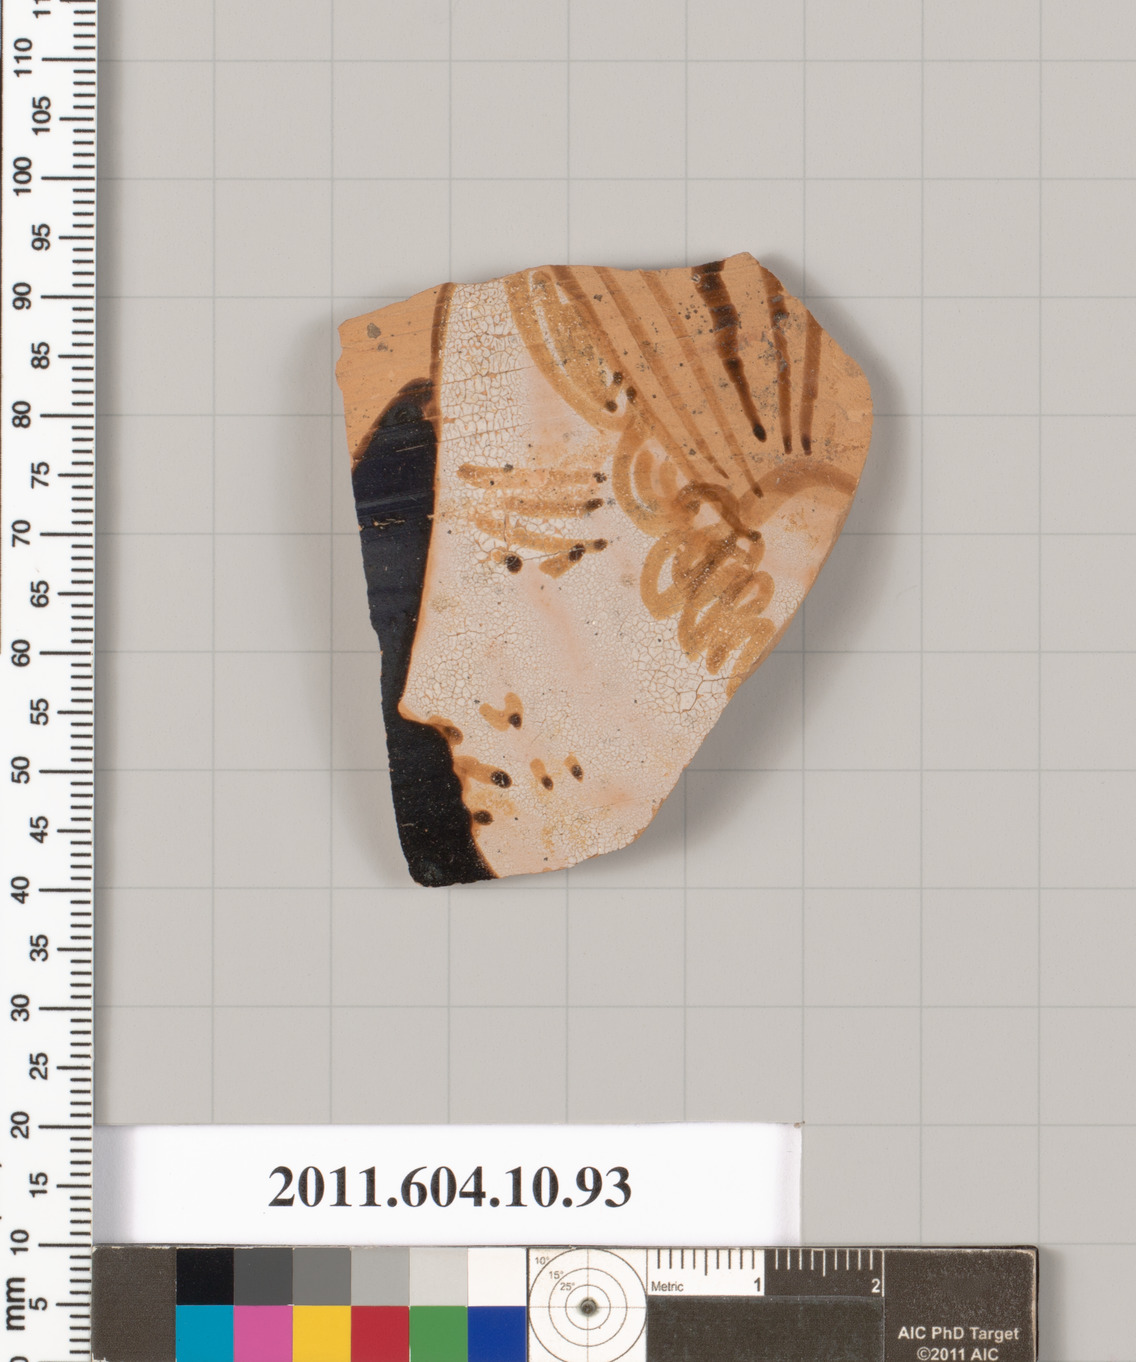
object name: oinochoe fragment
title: Terracotta fragment of an oinochoe (jug)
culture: etruscan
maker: torcop group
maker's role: artist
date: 367-335 BCE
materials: terracotta